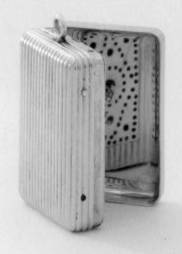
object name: music box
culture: swiss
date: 1800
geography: switzerland